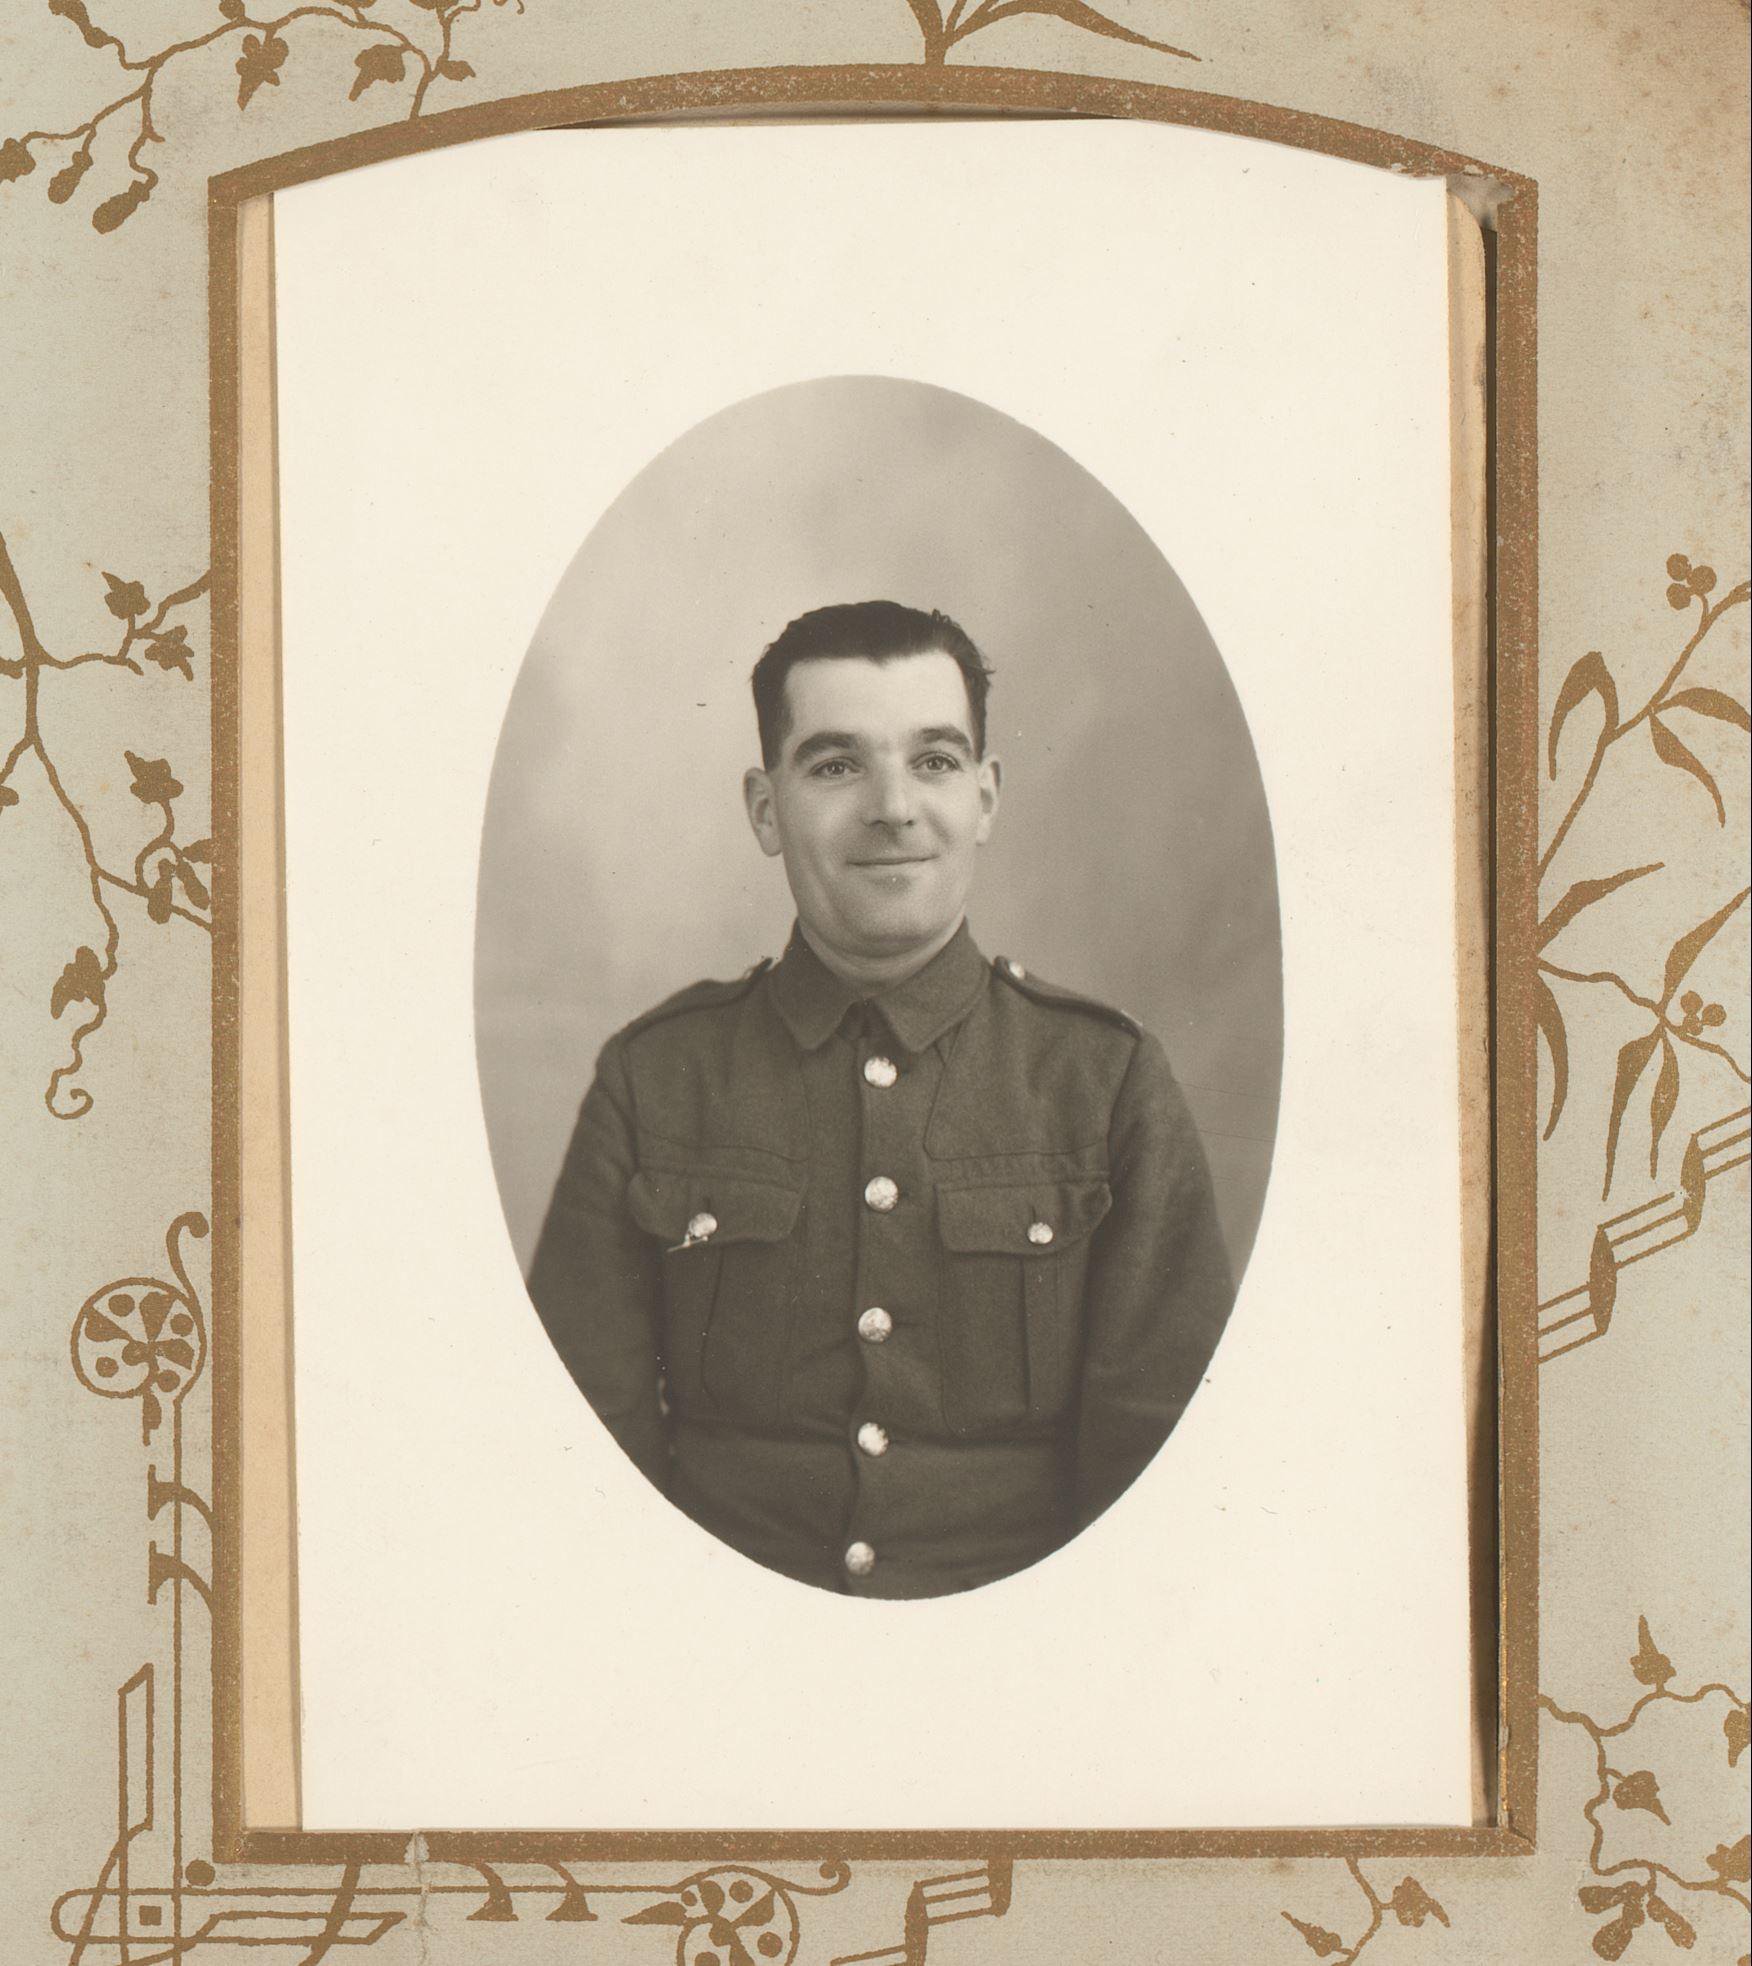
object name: photograph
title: Portret van een man in uniform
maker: Anonymous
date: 1899-1920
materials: photographic support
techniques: gelatin silver print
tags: adult man, historical persons, (military) uniforms